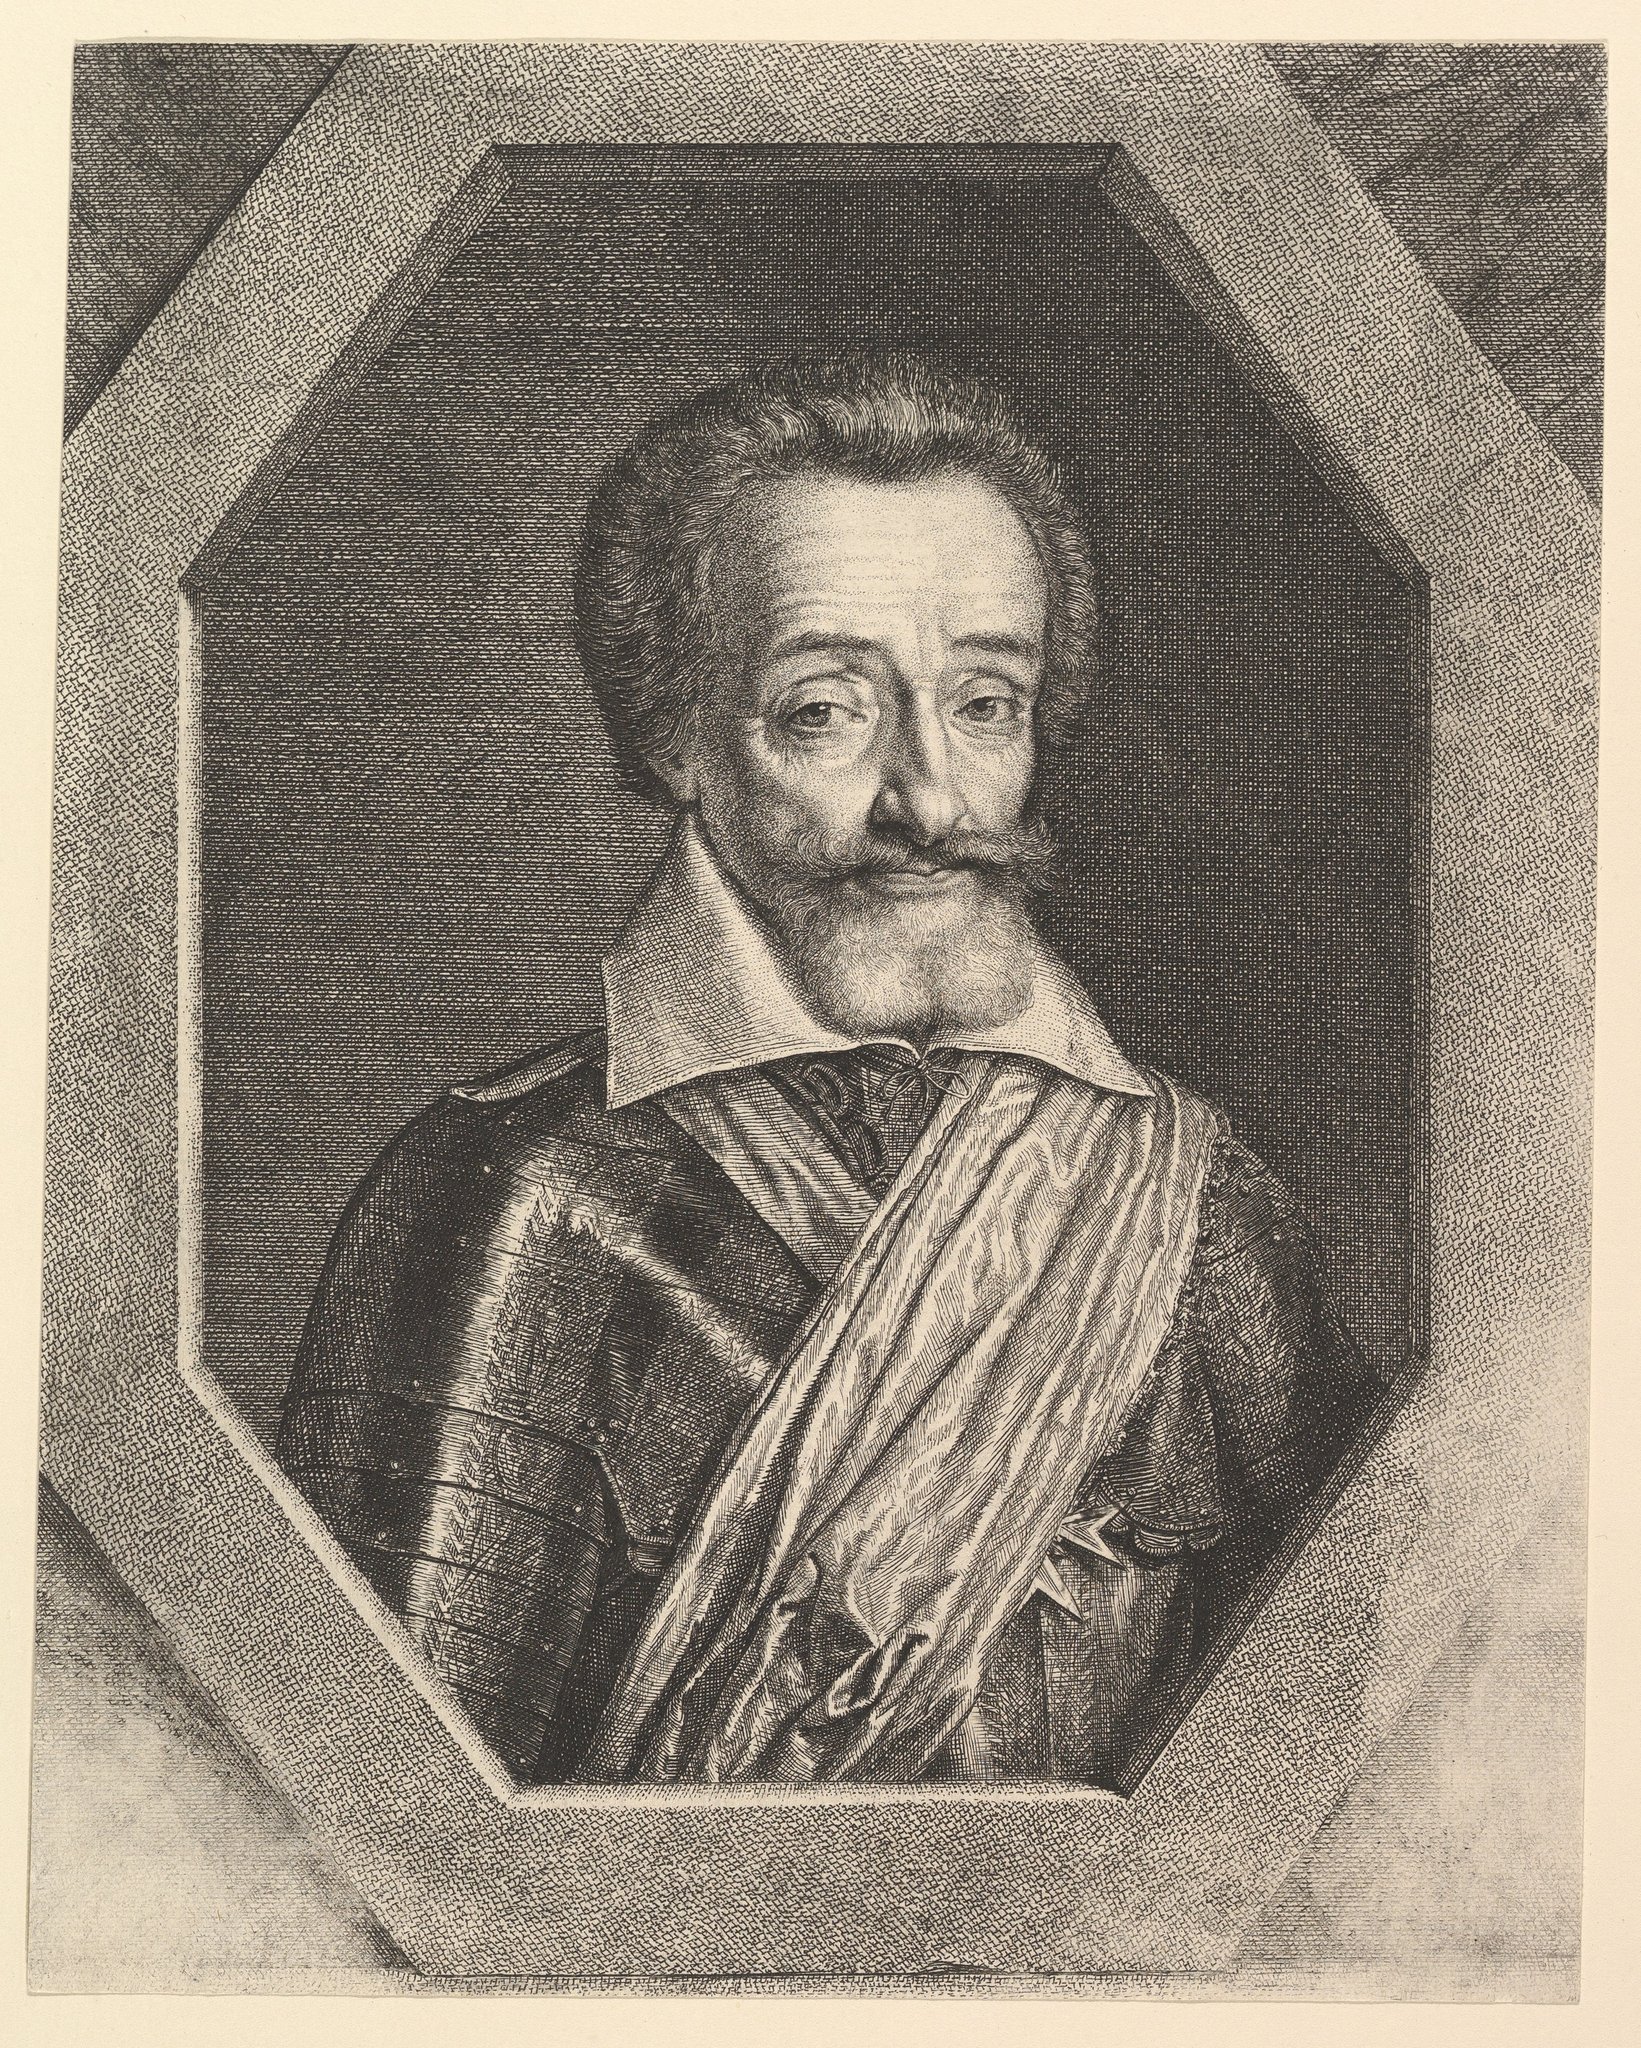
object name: print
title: Henri IV, roi de France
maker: jean morin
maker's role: artist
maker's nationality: french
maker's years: 1605-1650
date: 1605-1650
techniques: etching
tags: men,portraits